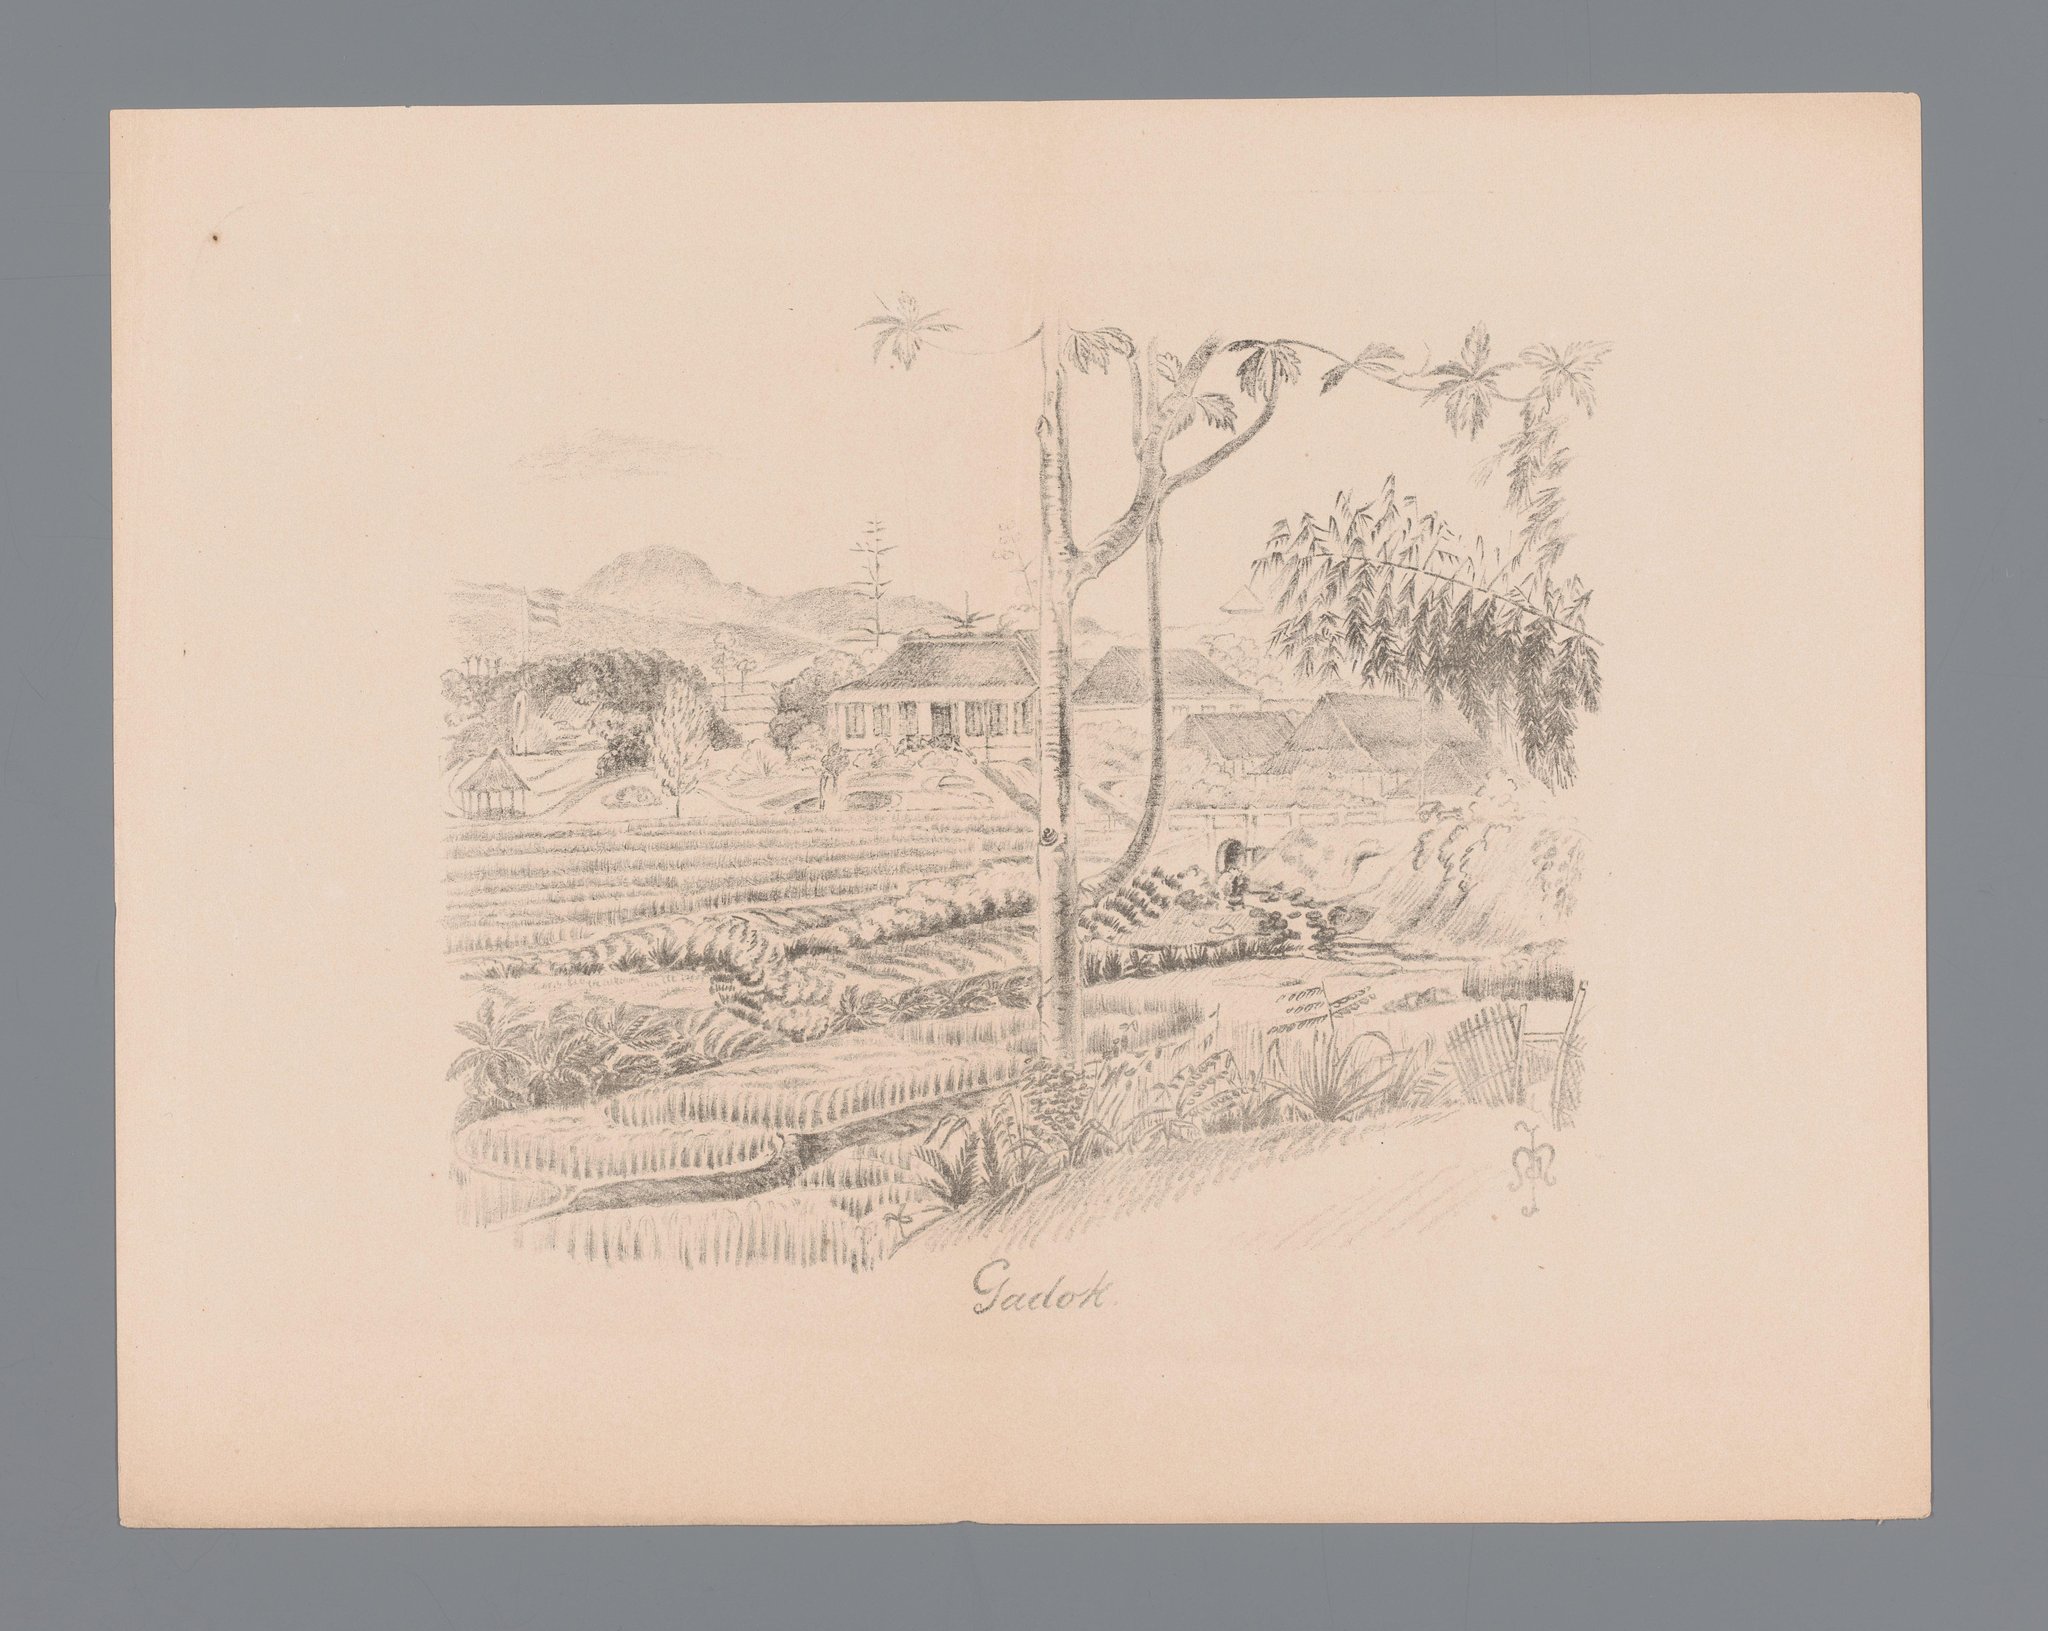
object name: print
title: Bladen uit een Indisch schetsboek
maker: willem mathol de jong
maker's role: print maker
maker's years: 1828-1886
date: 1838-1886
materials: paper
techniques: lithograph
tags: field filled with a crop, city-view in general; 'veduta'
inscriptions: collector's mark: Lugt 2228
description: In de voorgrond liggen velden met gewassen, daarachter huizen. Maakt deel uit van een omslag met twaalf prenten.